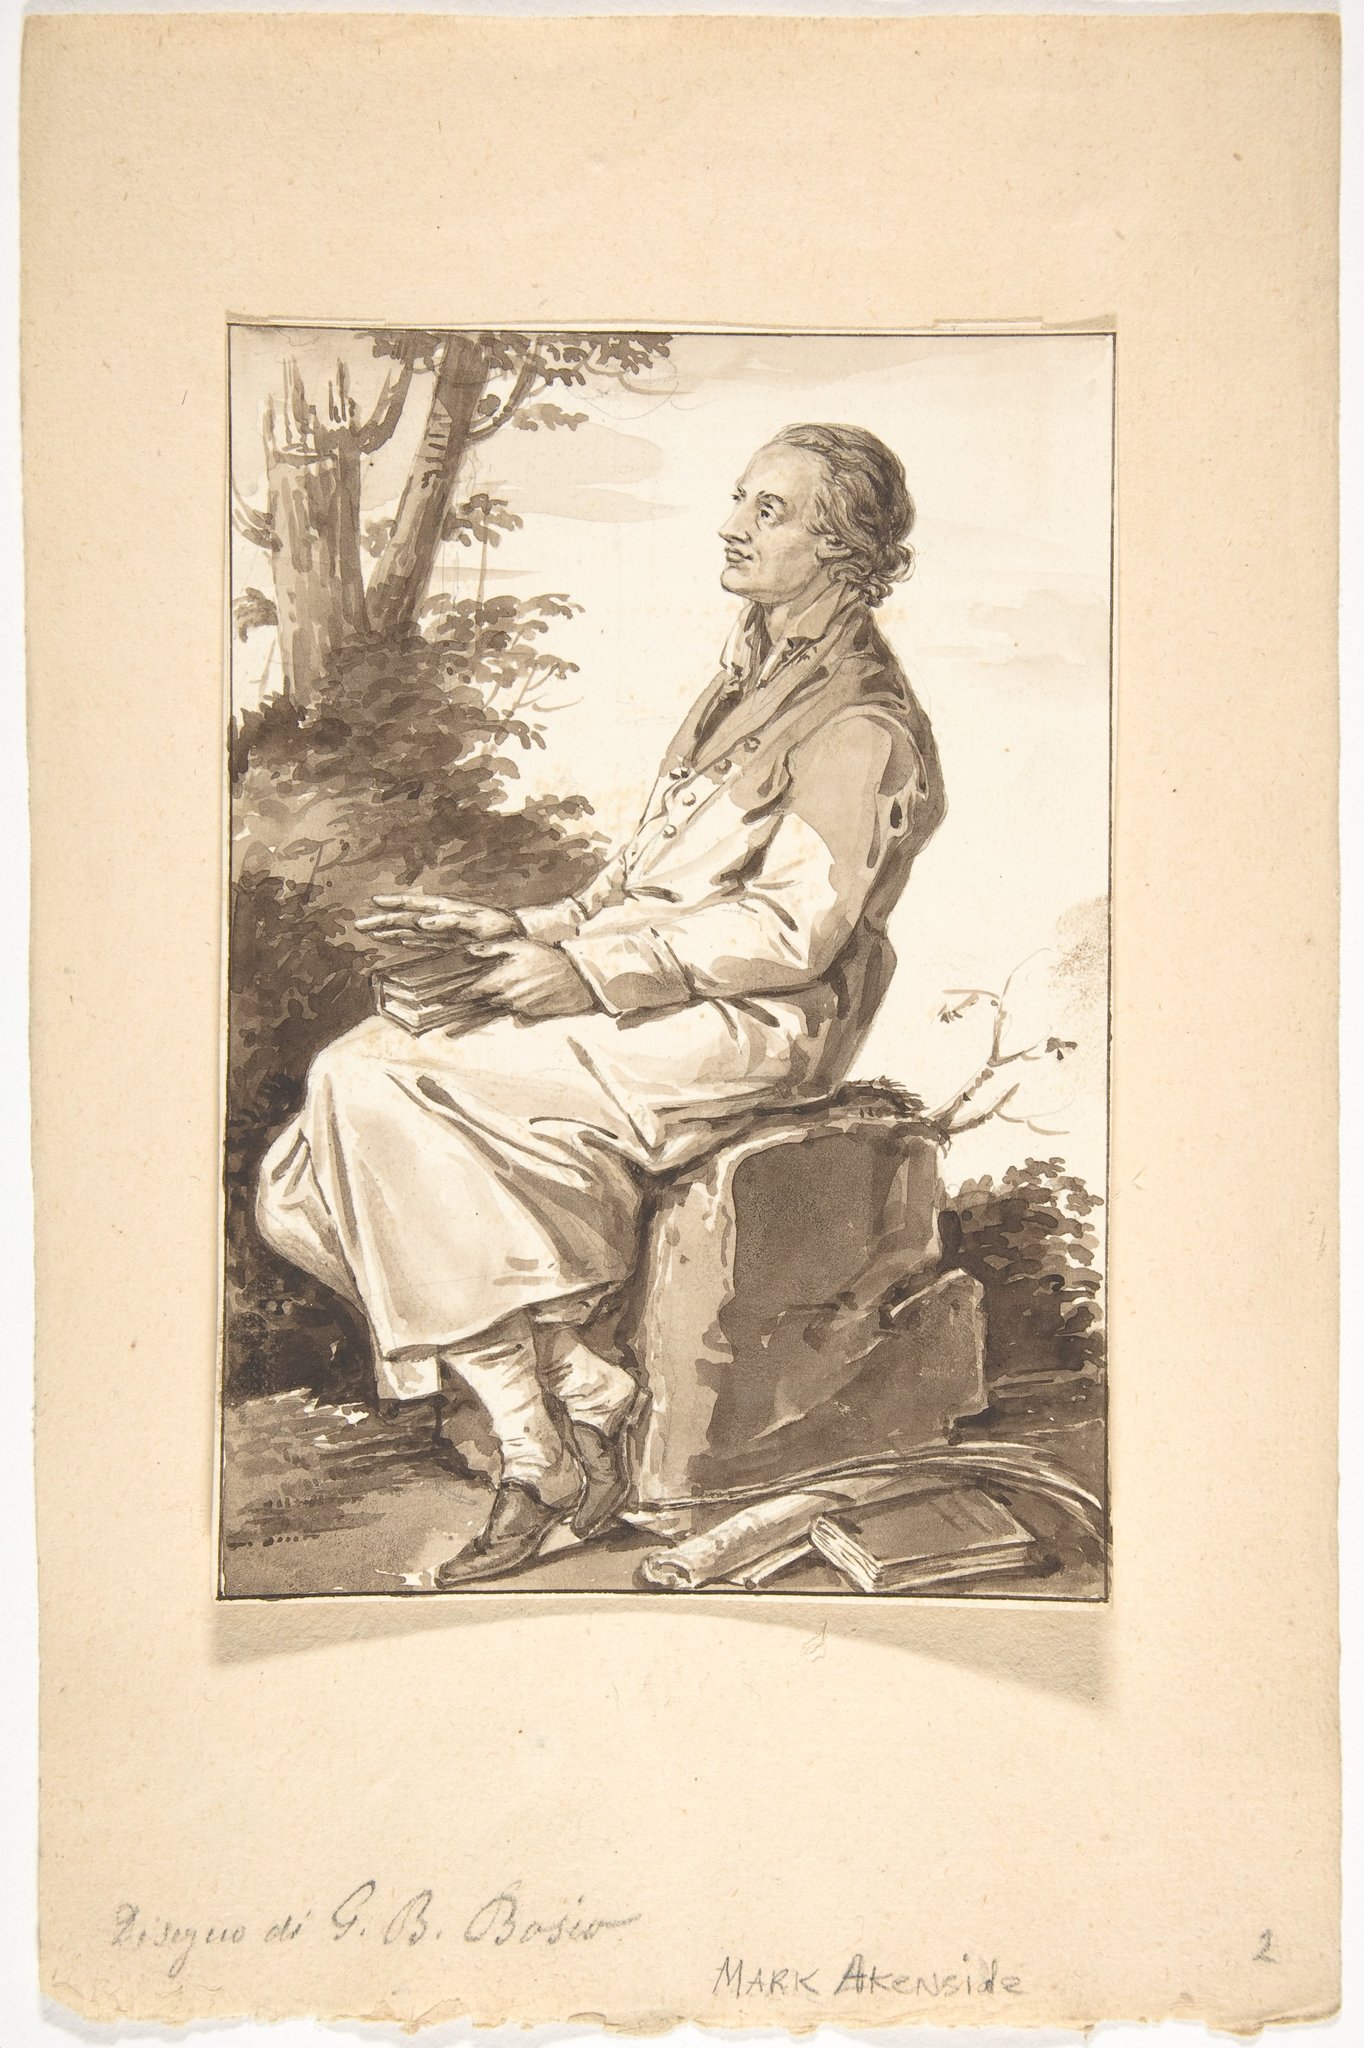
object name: drawing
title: Portrait of Mark Akenside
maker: jean-baptiste-françois bosio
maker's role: artist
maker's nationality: french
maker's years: 1764-1827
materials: graphite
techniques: brush, wash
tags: men,portraits